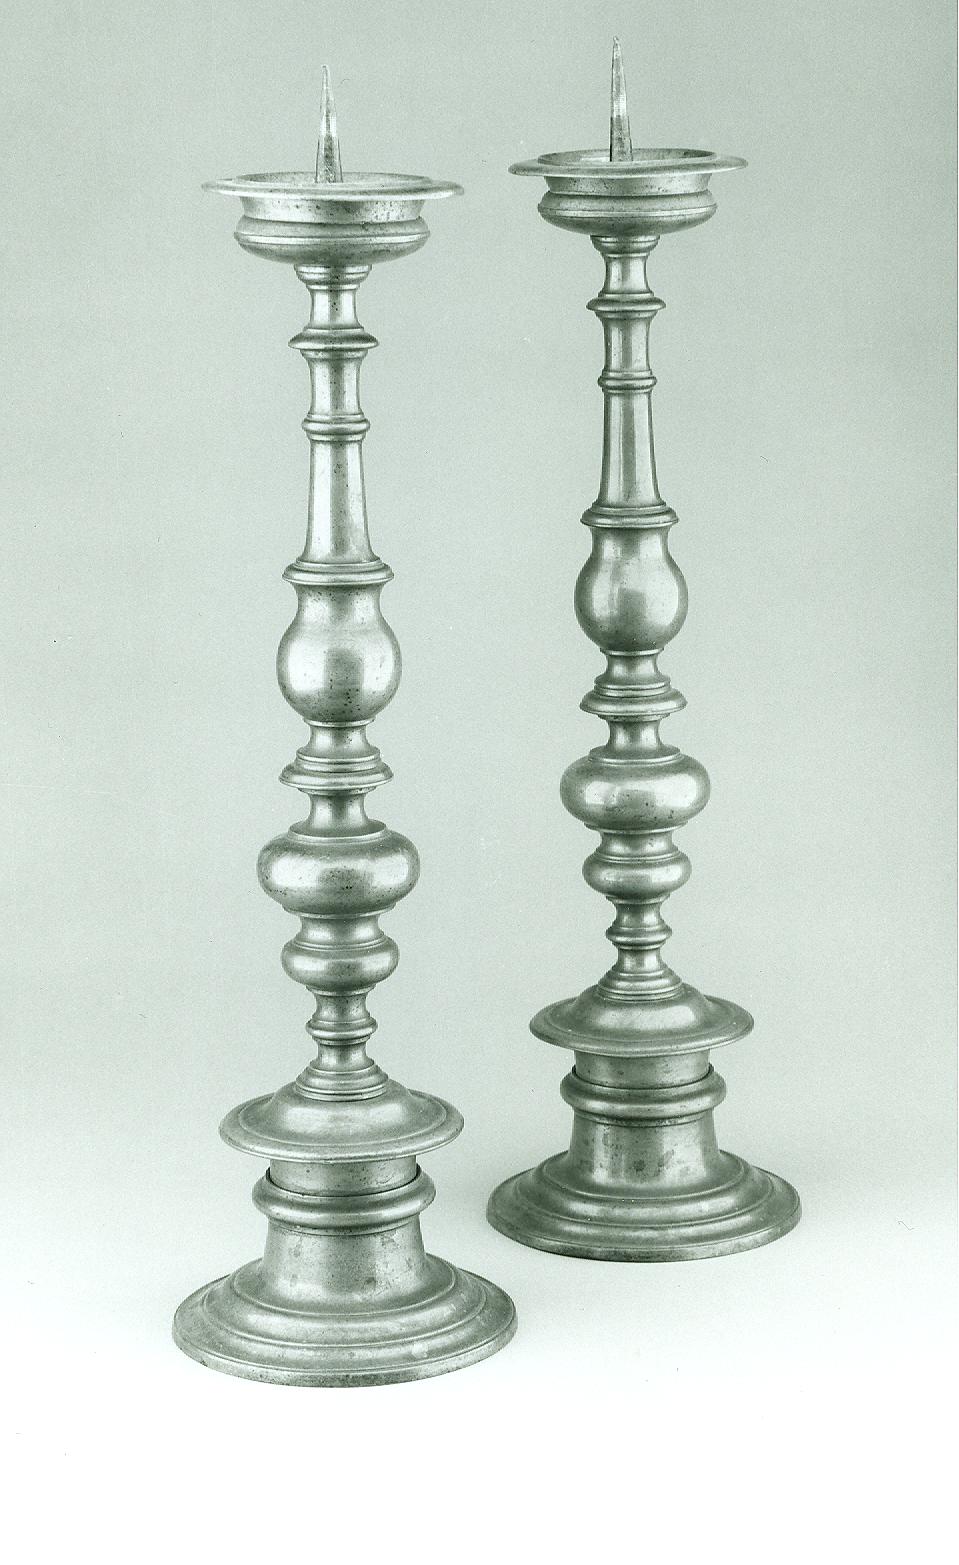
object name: candlestick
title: Altar Candlestick (pair with .1448)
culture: german or south netherlandish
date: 1601-1700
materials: brass